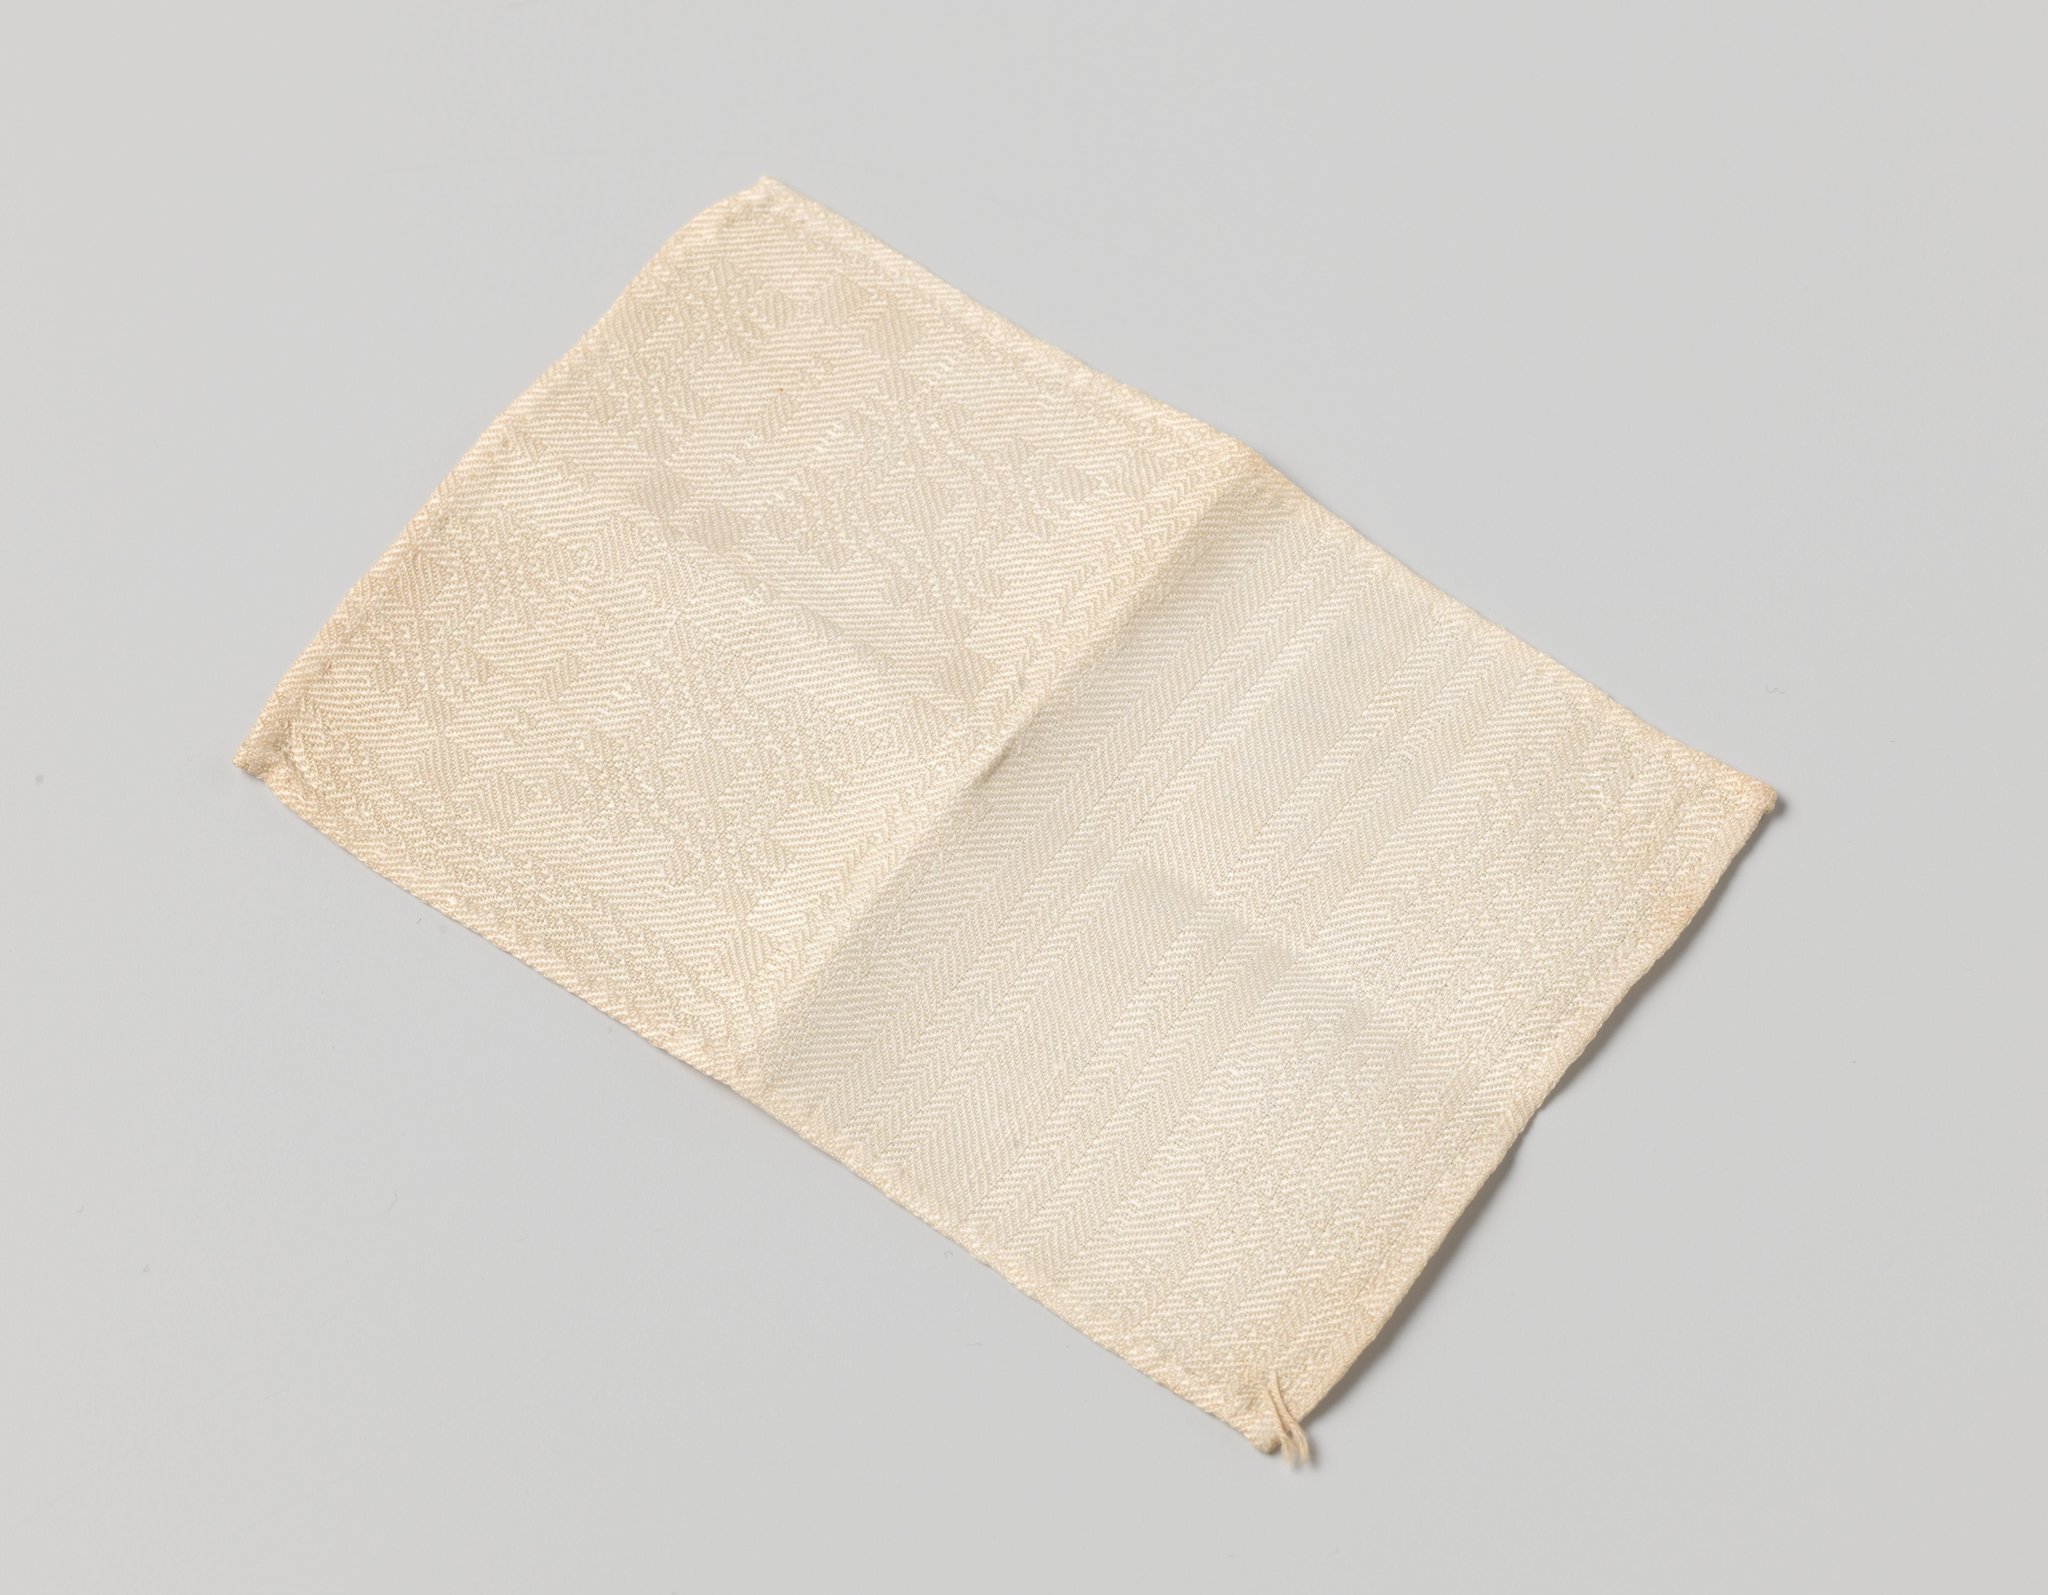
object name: napkin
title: Servet, met ingeweven pellenpatroon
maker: Anonymous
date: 1750-1800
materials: linen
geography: netherlands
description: Servet van linnen met pellenpatroon, geknipt uit grotere lap; aan vier zijden omgezoomd..